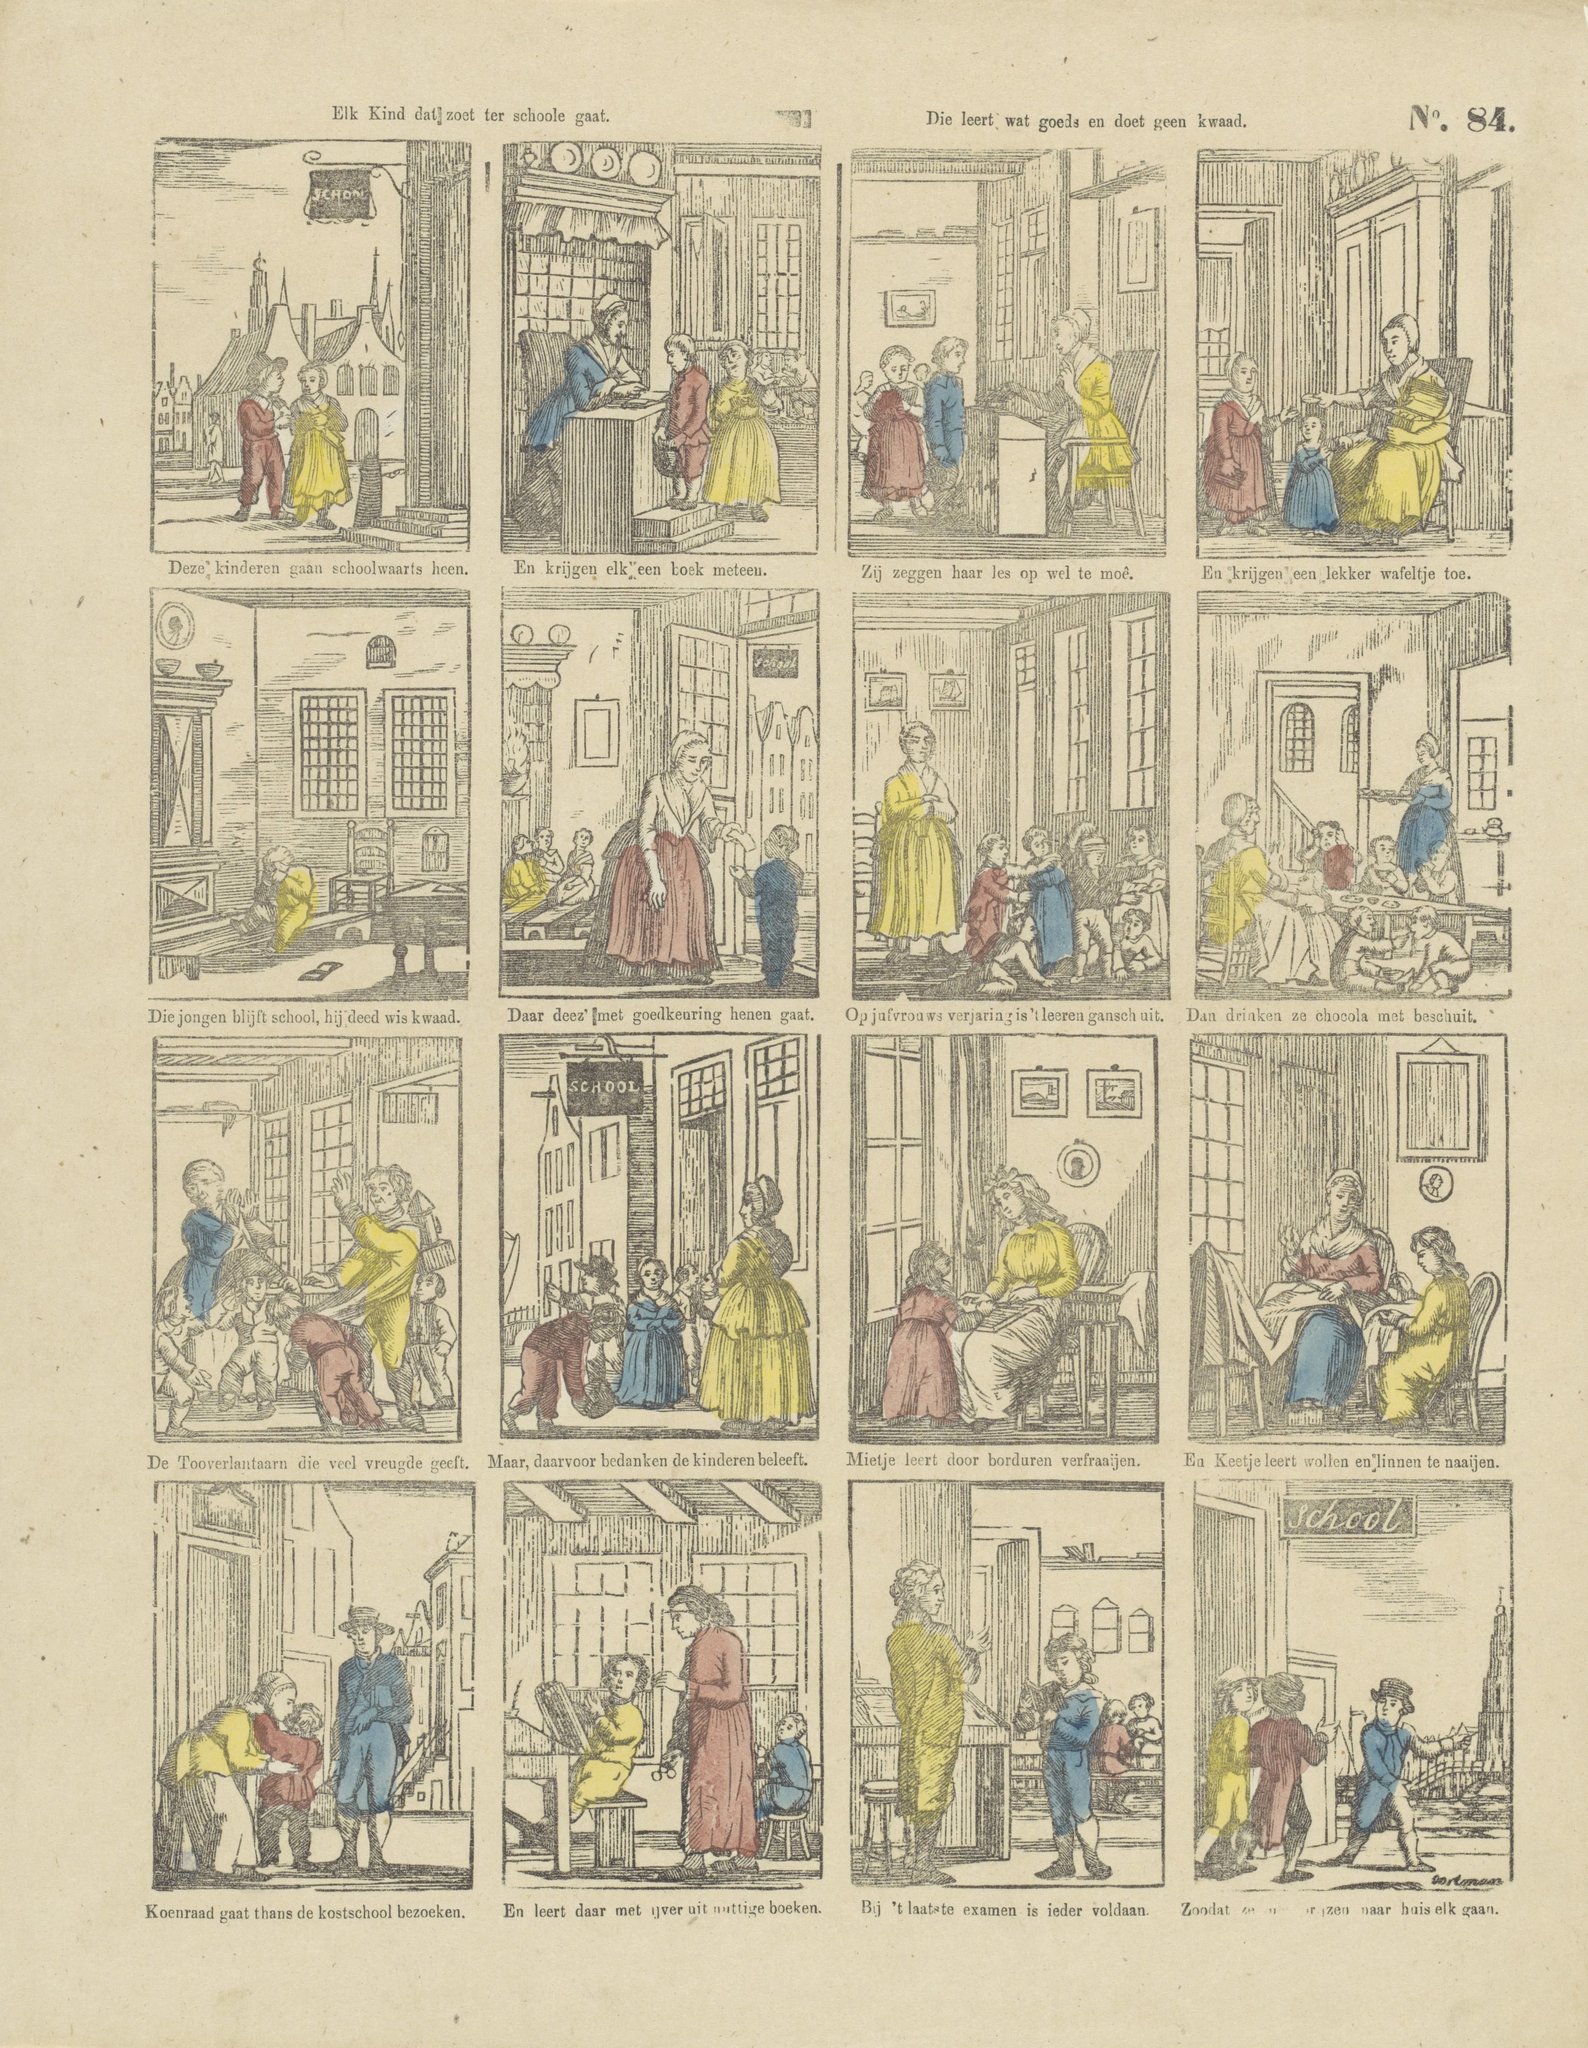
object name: print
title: Elk kind dat zoet ter schoole gaat. / Die leert wat goeds en doet geen kwaad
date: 1850-1870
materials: paper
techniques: colour, letterpress printing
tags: child and school (~ games and plays), going to school, games at school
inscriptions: collector's mark: Lugt 2760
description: Blad met 16 voorstellingen van schoolgaande kinderen. Onder elke voorstelling een onderschrift. Genummerd rechtsboven: No. 84.